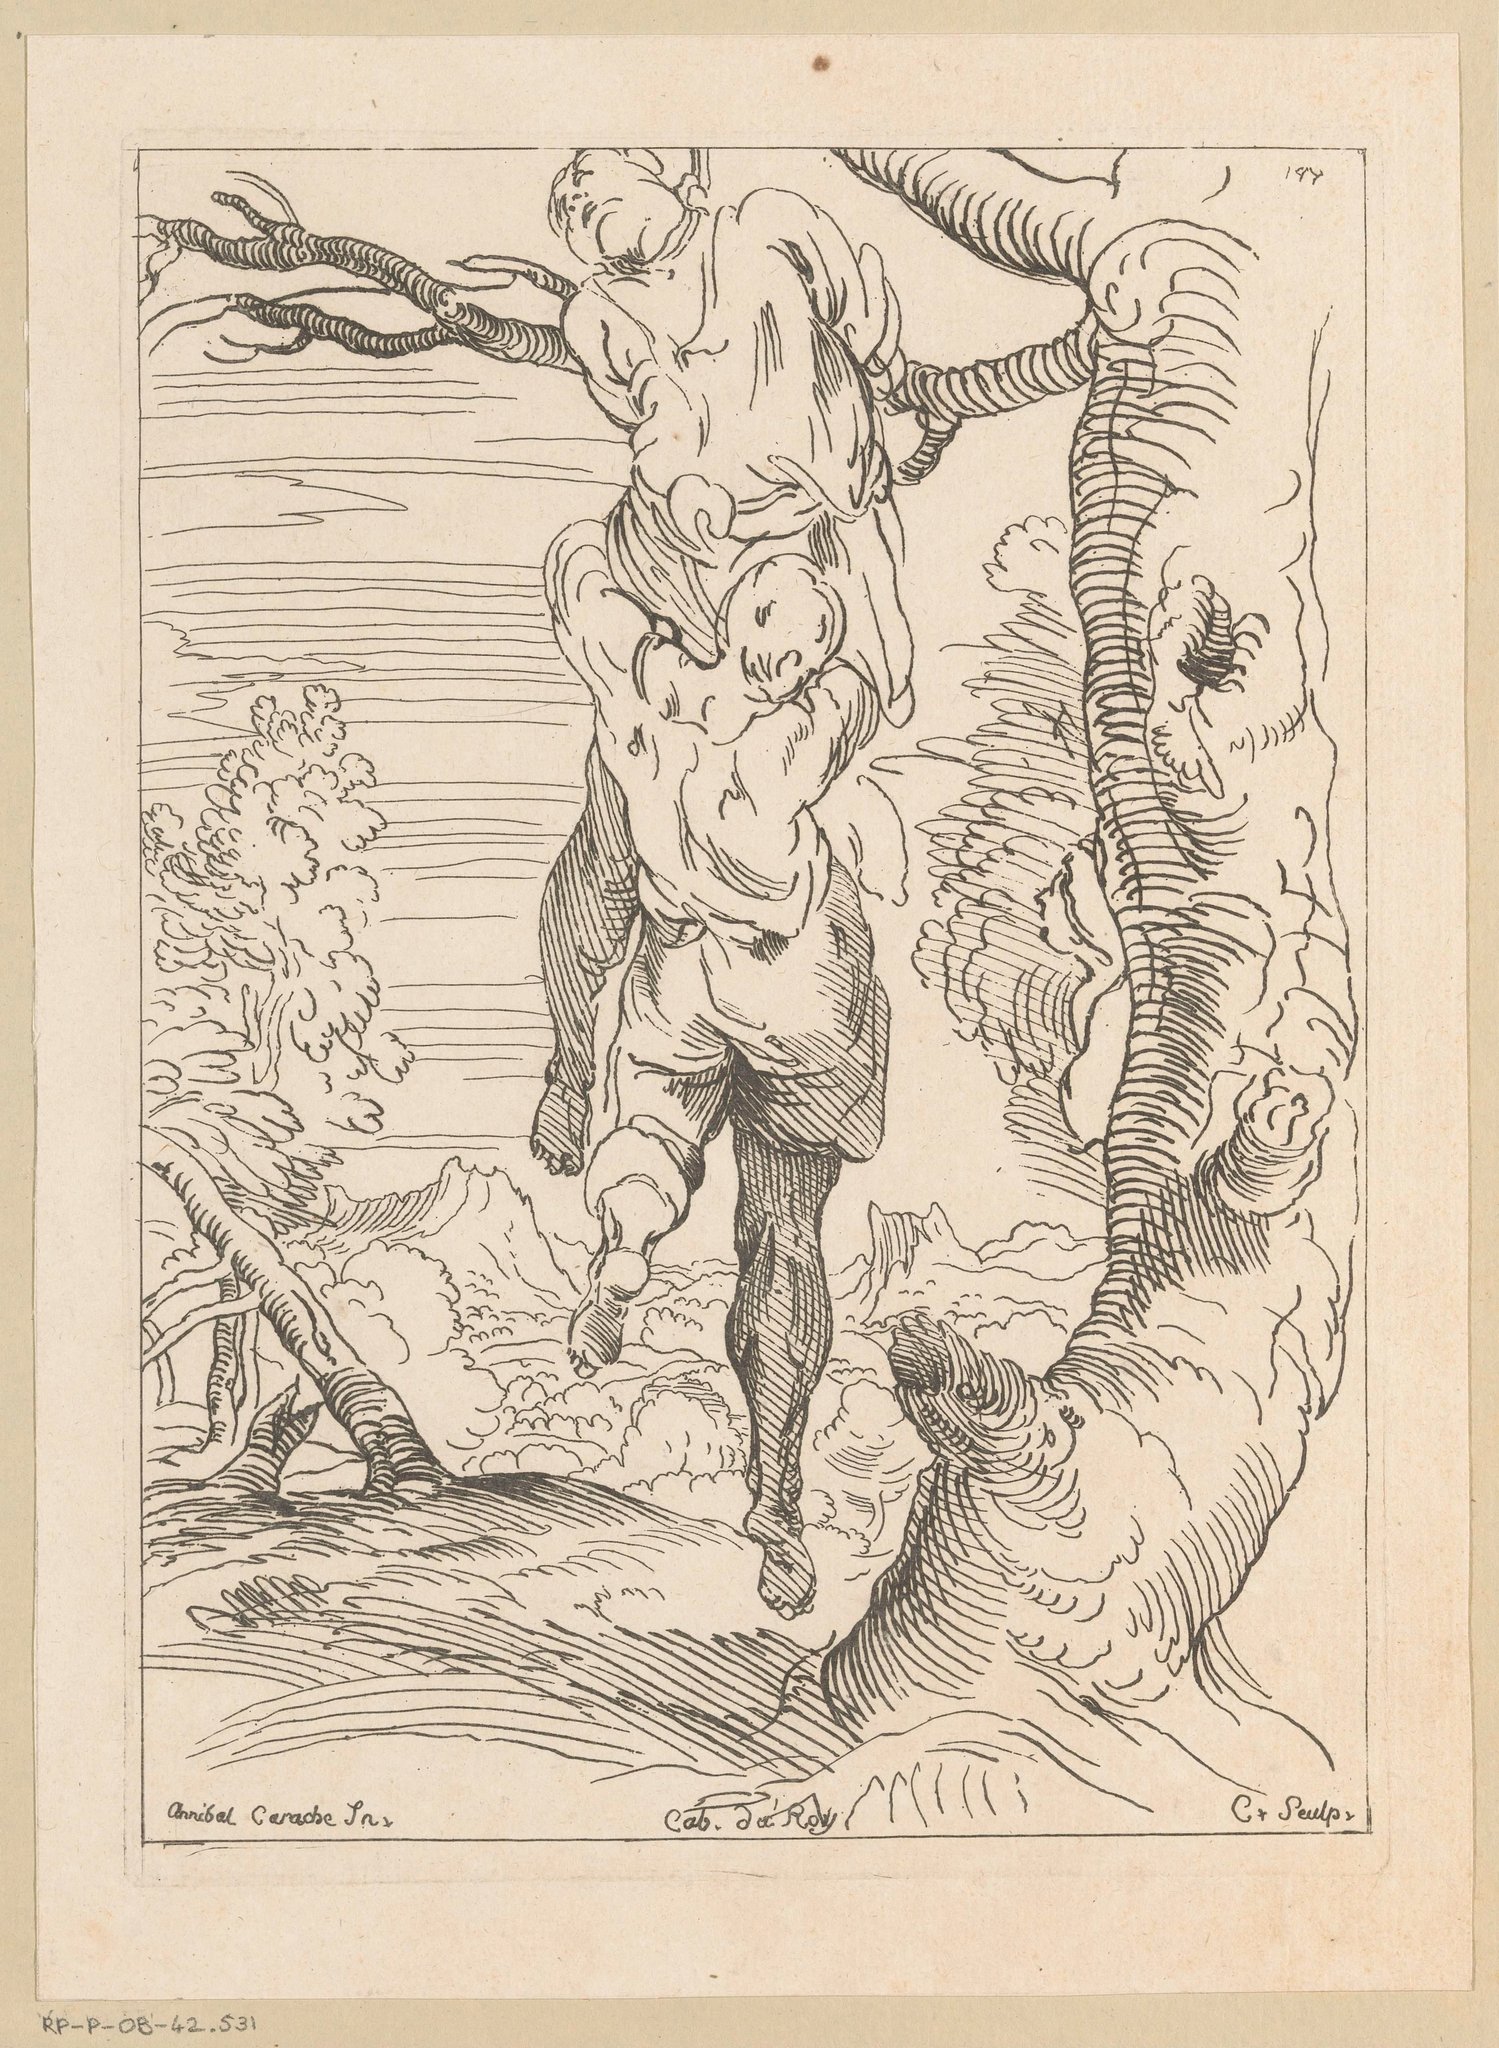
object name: print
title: Cabinet du Roy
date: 1702-1765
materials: paper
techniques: etching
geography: france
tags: trees, violent death by hanging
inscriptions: collector's mark: Lugt 240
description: Maakt deel uit van een serie getiteld: "Cabinet du Roy" van 222 etsen naar tekeningen uit de Franse koninklijke collectie.